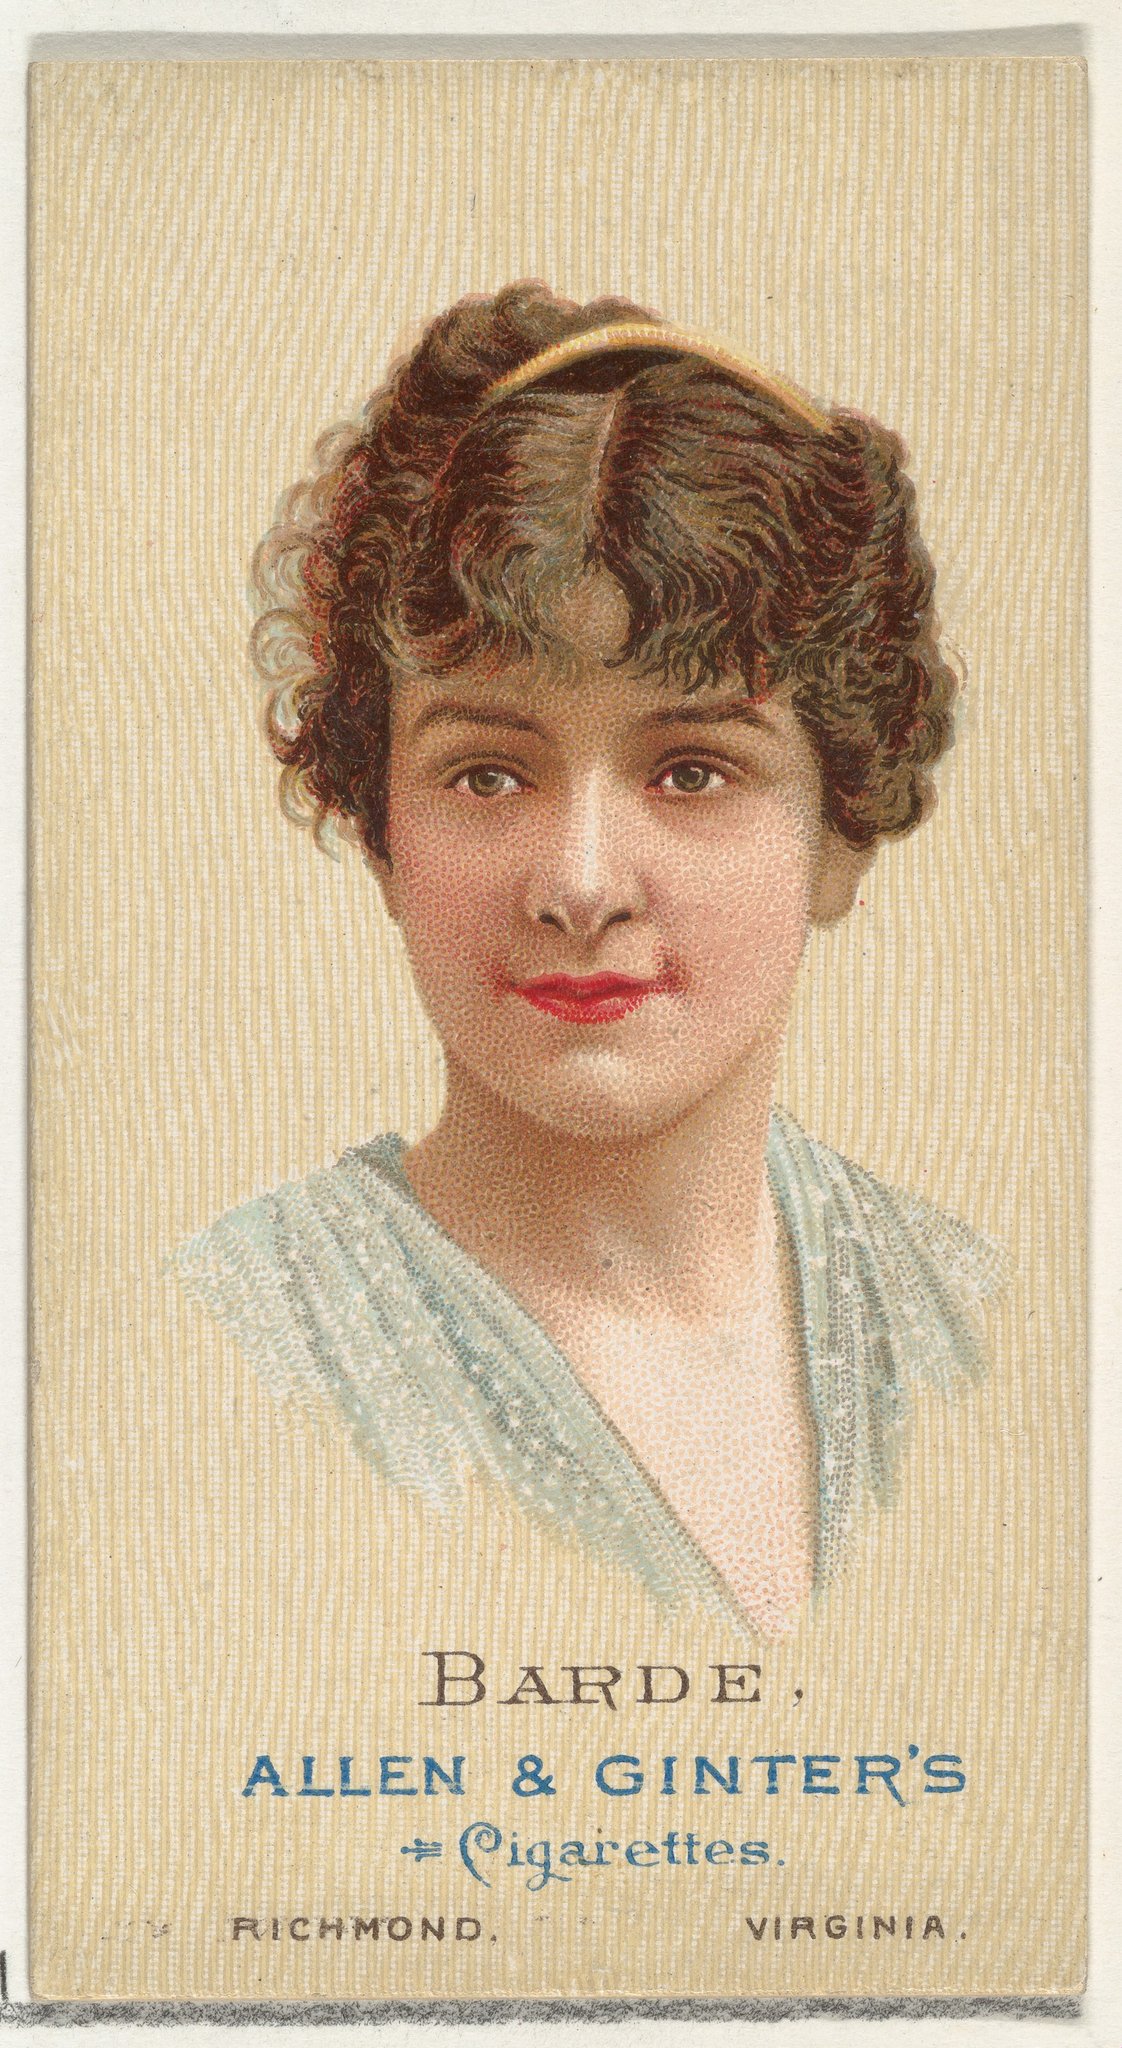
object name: print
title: Barde, from World's Beauties, Series 2 (N27) for Allen & Ginter Cigarettes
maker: allen & ginter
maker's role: publisher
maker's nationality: american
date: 1888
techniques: color lithograph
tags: women